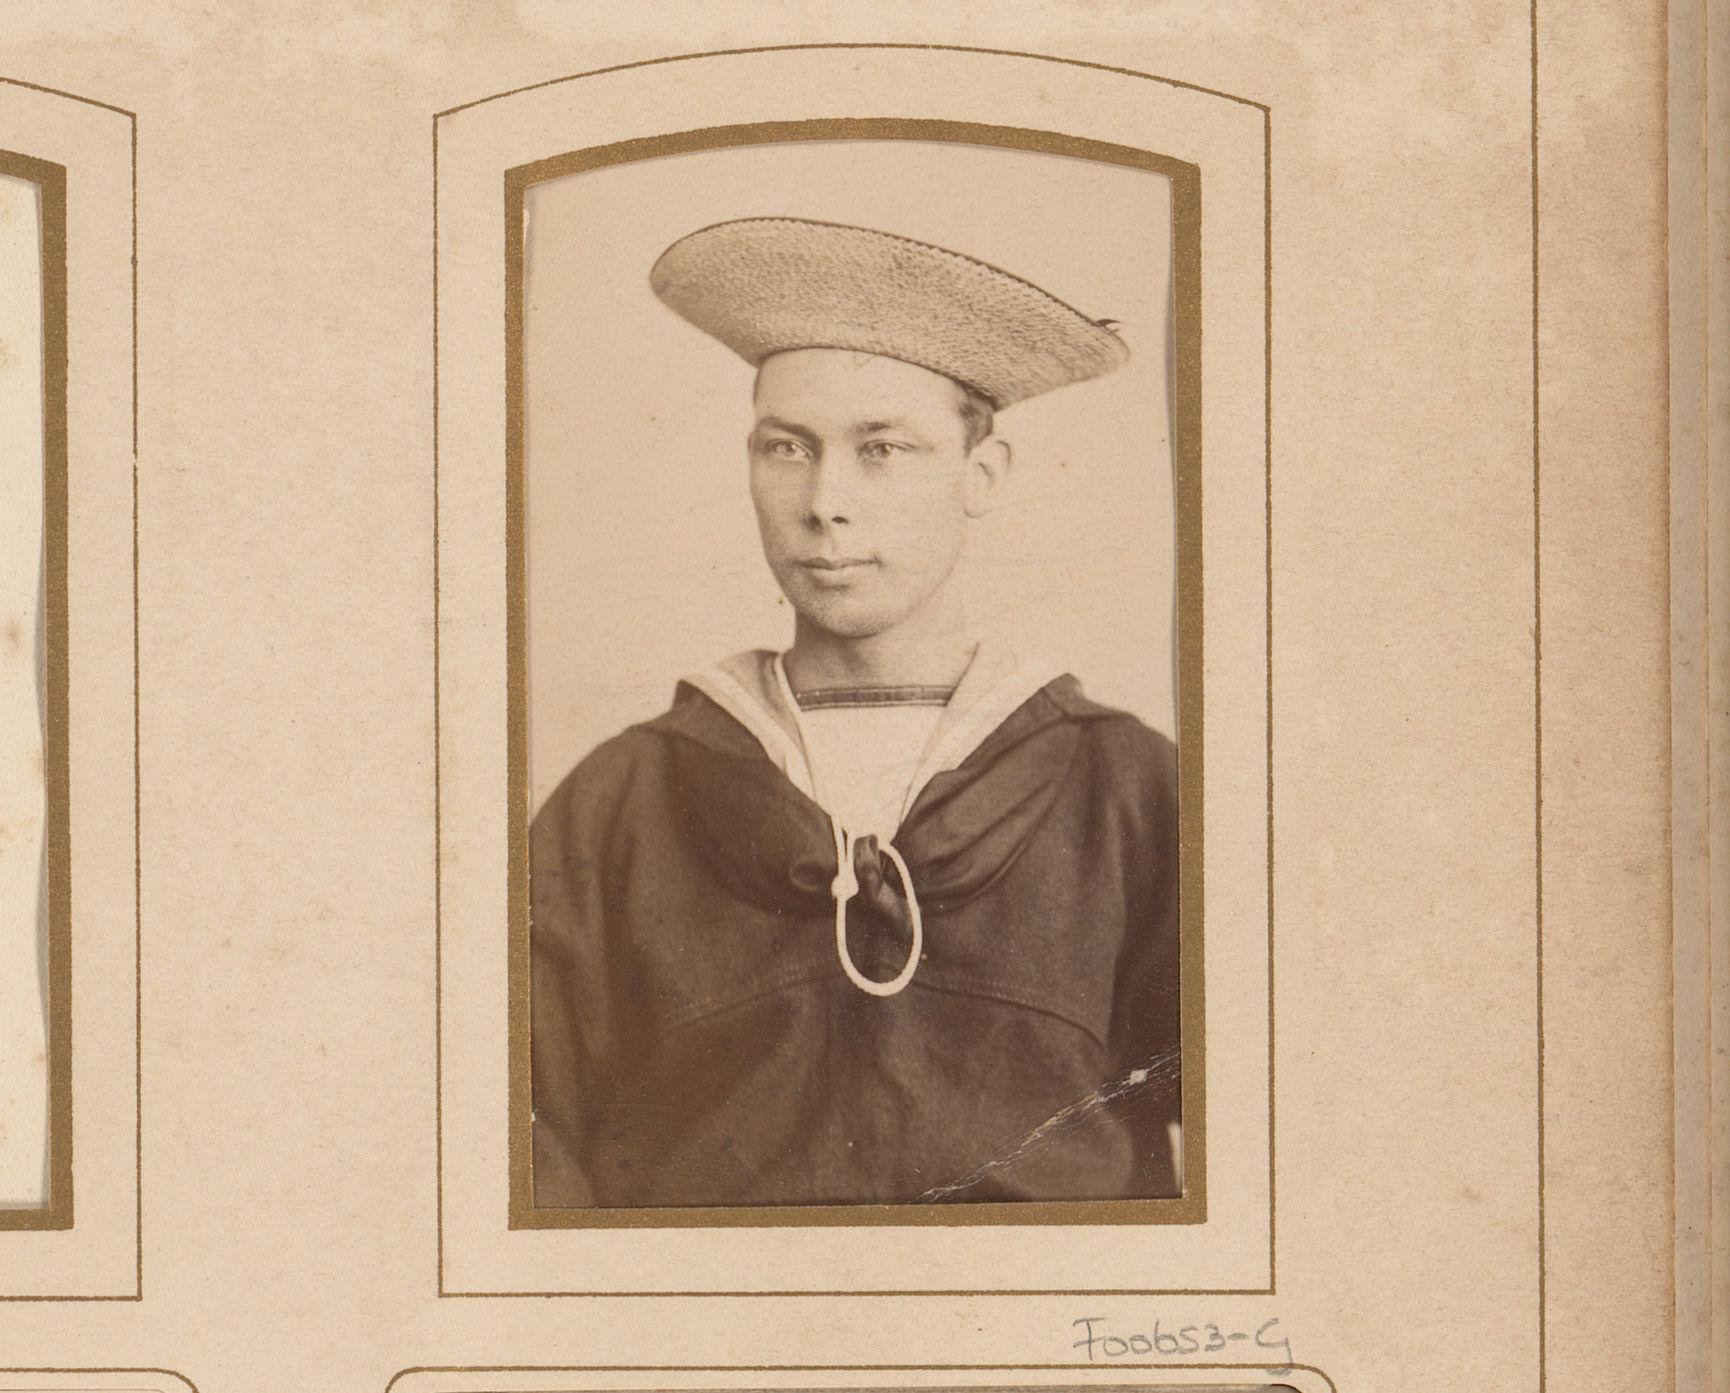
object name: photograph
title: Portret van een jonge man in matrozen uniform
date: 1870-1900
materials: cardboard, photographic support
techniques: albumen print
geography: portsmouth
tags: ensemble of pieces of clothing: sailor suit, historical persons, youth, adolescent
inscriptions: inscription: ‘Artists and/ Photographers/ Symonds & Co/ 39 High Street/ Portsmouth/ OLD PHOTOGRAPHS COPIED FOR C.D.V.S./ OR ENLARGEMENTS.’